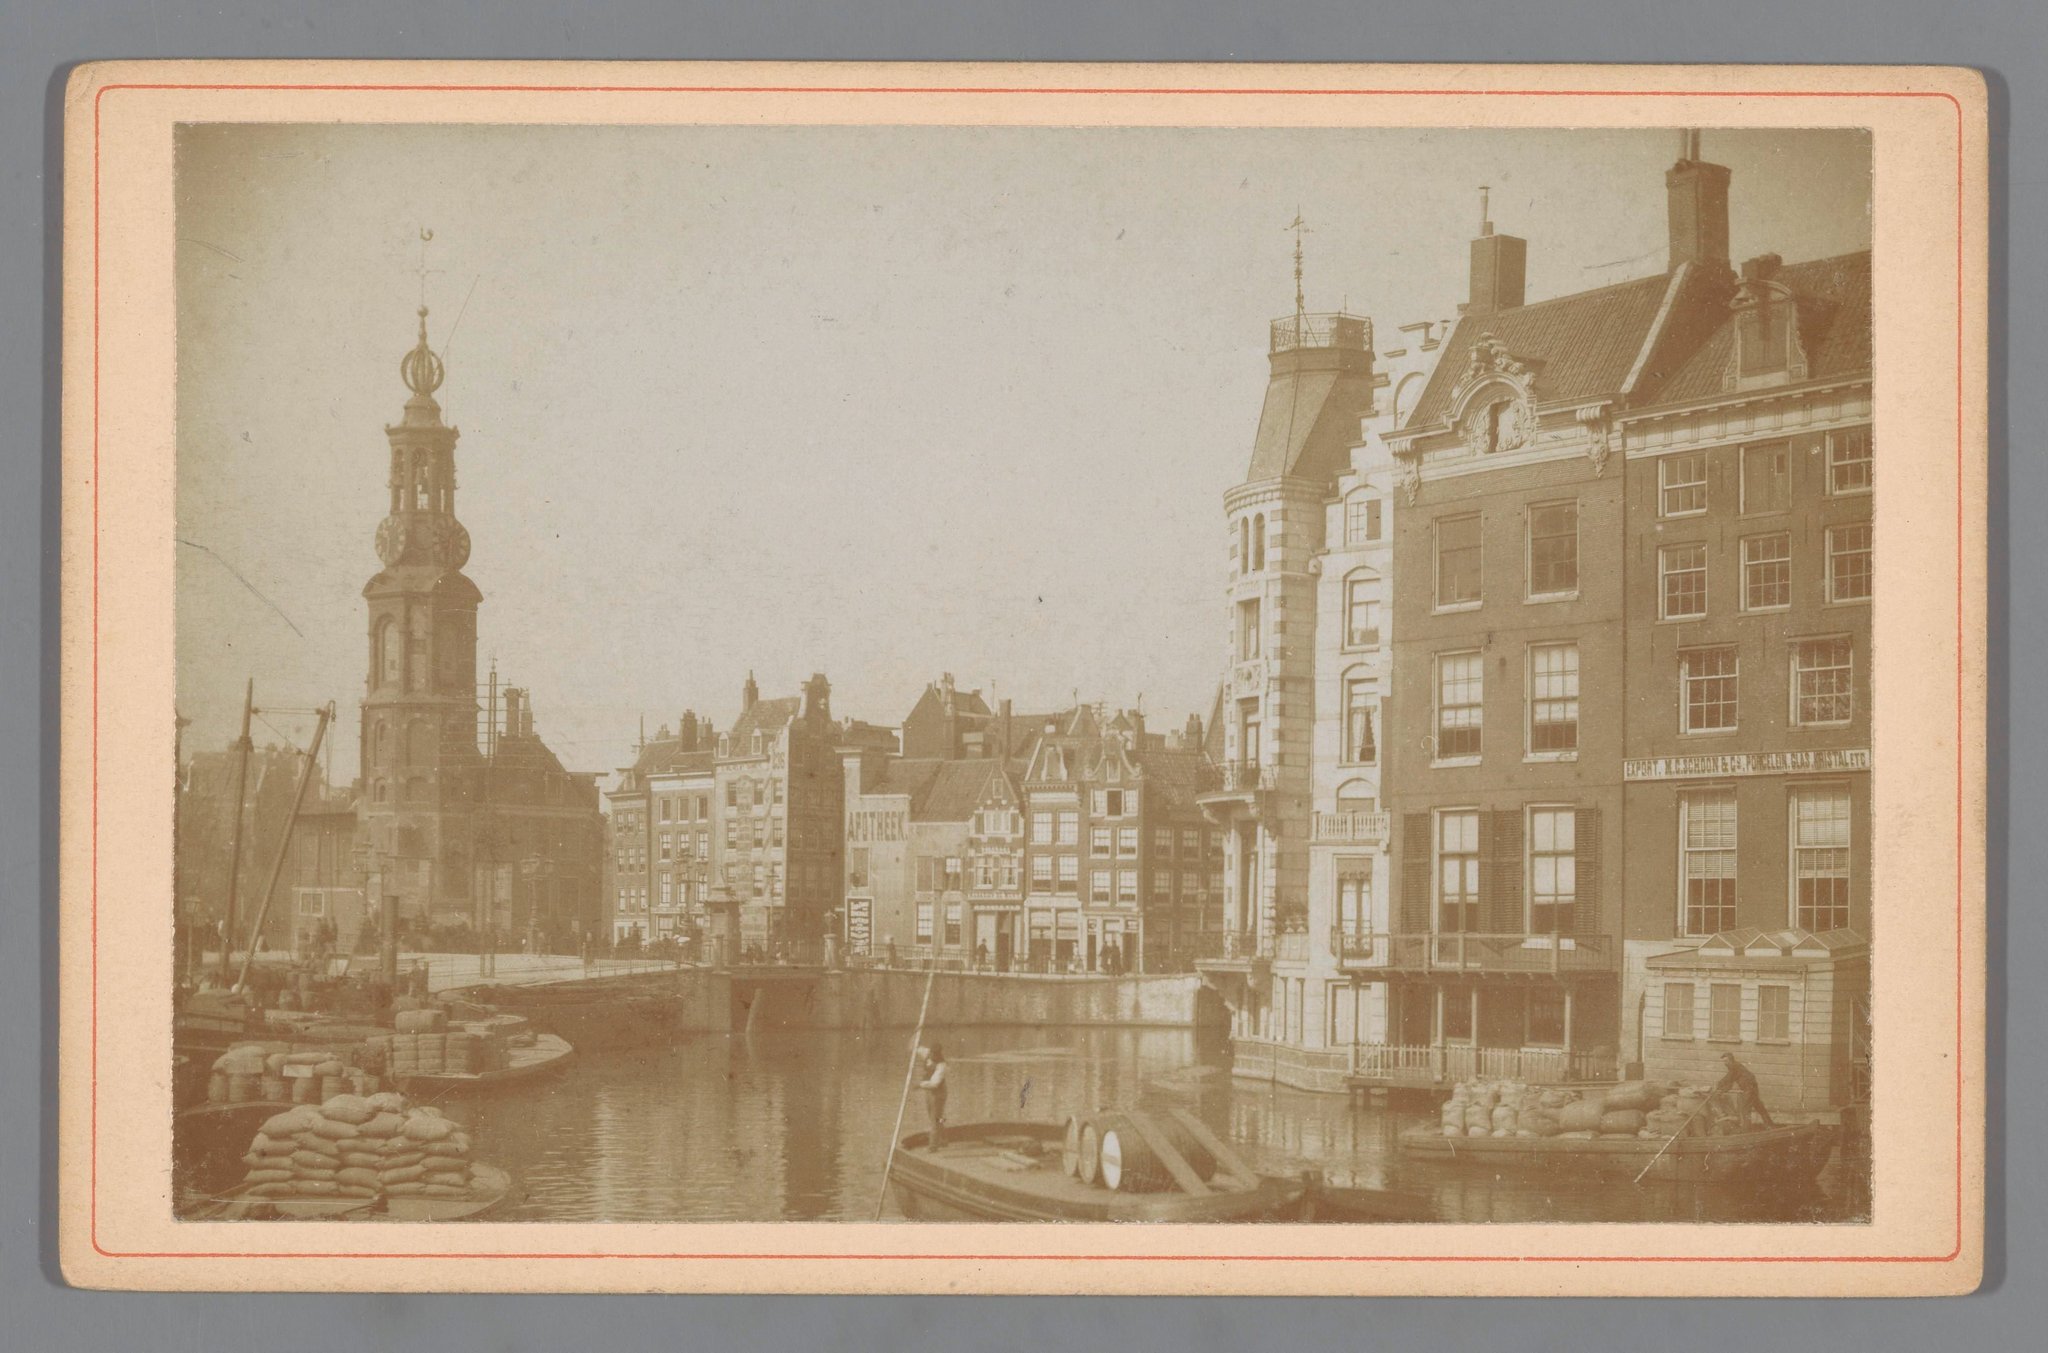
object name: photograph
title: Gezicht op de Amstel in Amsterdam, met links de Munttoren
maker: Anonymous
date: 1880-1920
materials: cardboard, photographic support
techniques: collodion silver print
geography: amsterdam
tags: tower, clock tower ~ monumental adornment, canals, waters (in city)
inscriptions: annotation: ‘De Binnen Amstel, ziende op de/ oude huizen aan het voormalige Schapenplein/ en op de oude achtergevels van de huizen/ in de Doelenstraet, allen afgebroken/ en vernieuwd, thans Het Muntplein.’